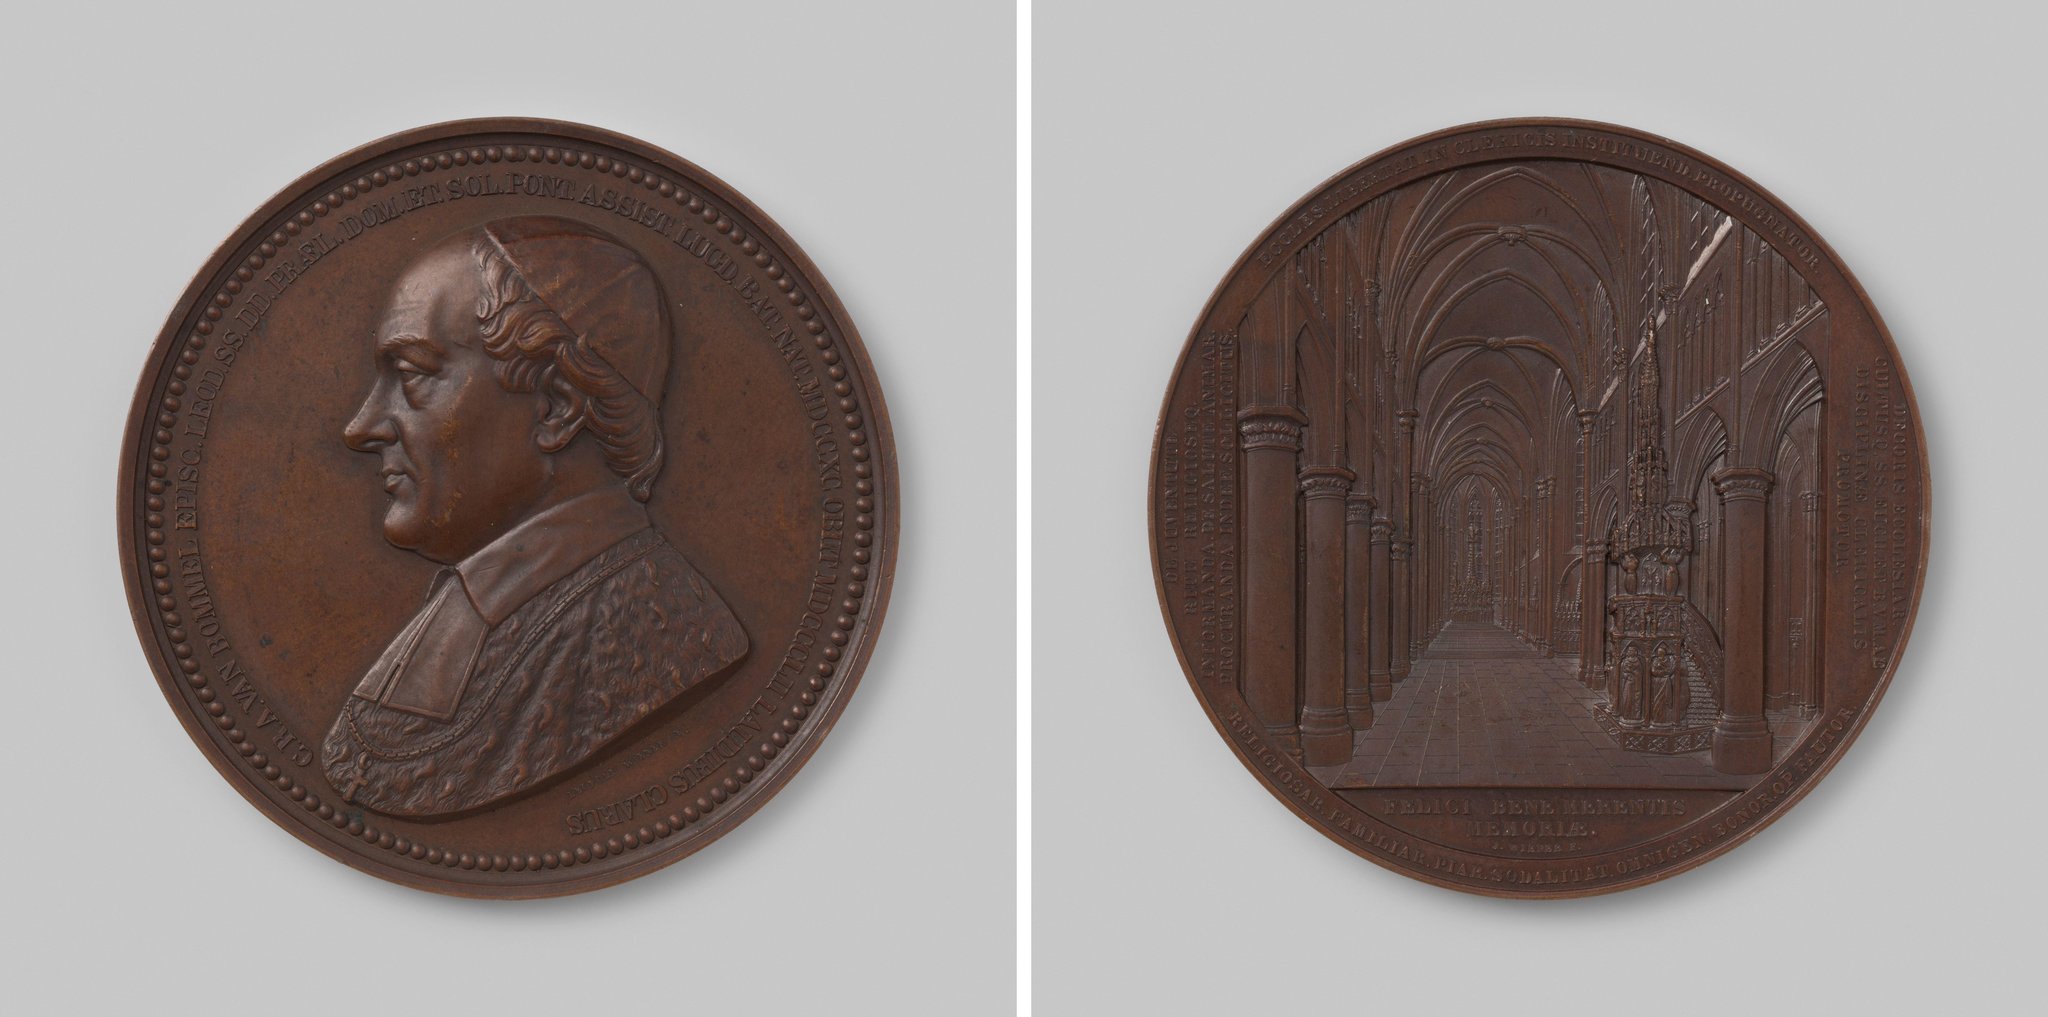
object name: history medal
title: Overlijden van Cornelis van Bommel, bisschop van Luik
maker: jacob wiener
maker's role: medailleur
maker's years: 1815-1899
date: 1852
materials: bronze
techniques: striking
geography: brussels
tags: cornelis richard anton van bommel, sint-pauluskerk (luik)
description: Bronzen penning. Voorzijde: borststuk man binnen omschrift. Keerzijde: interieur van St. Pauluskerk te Luik tussen opschriften, binnen omschrift; afsnede: opschrift